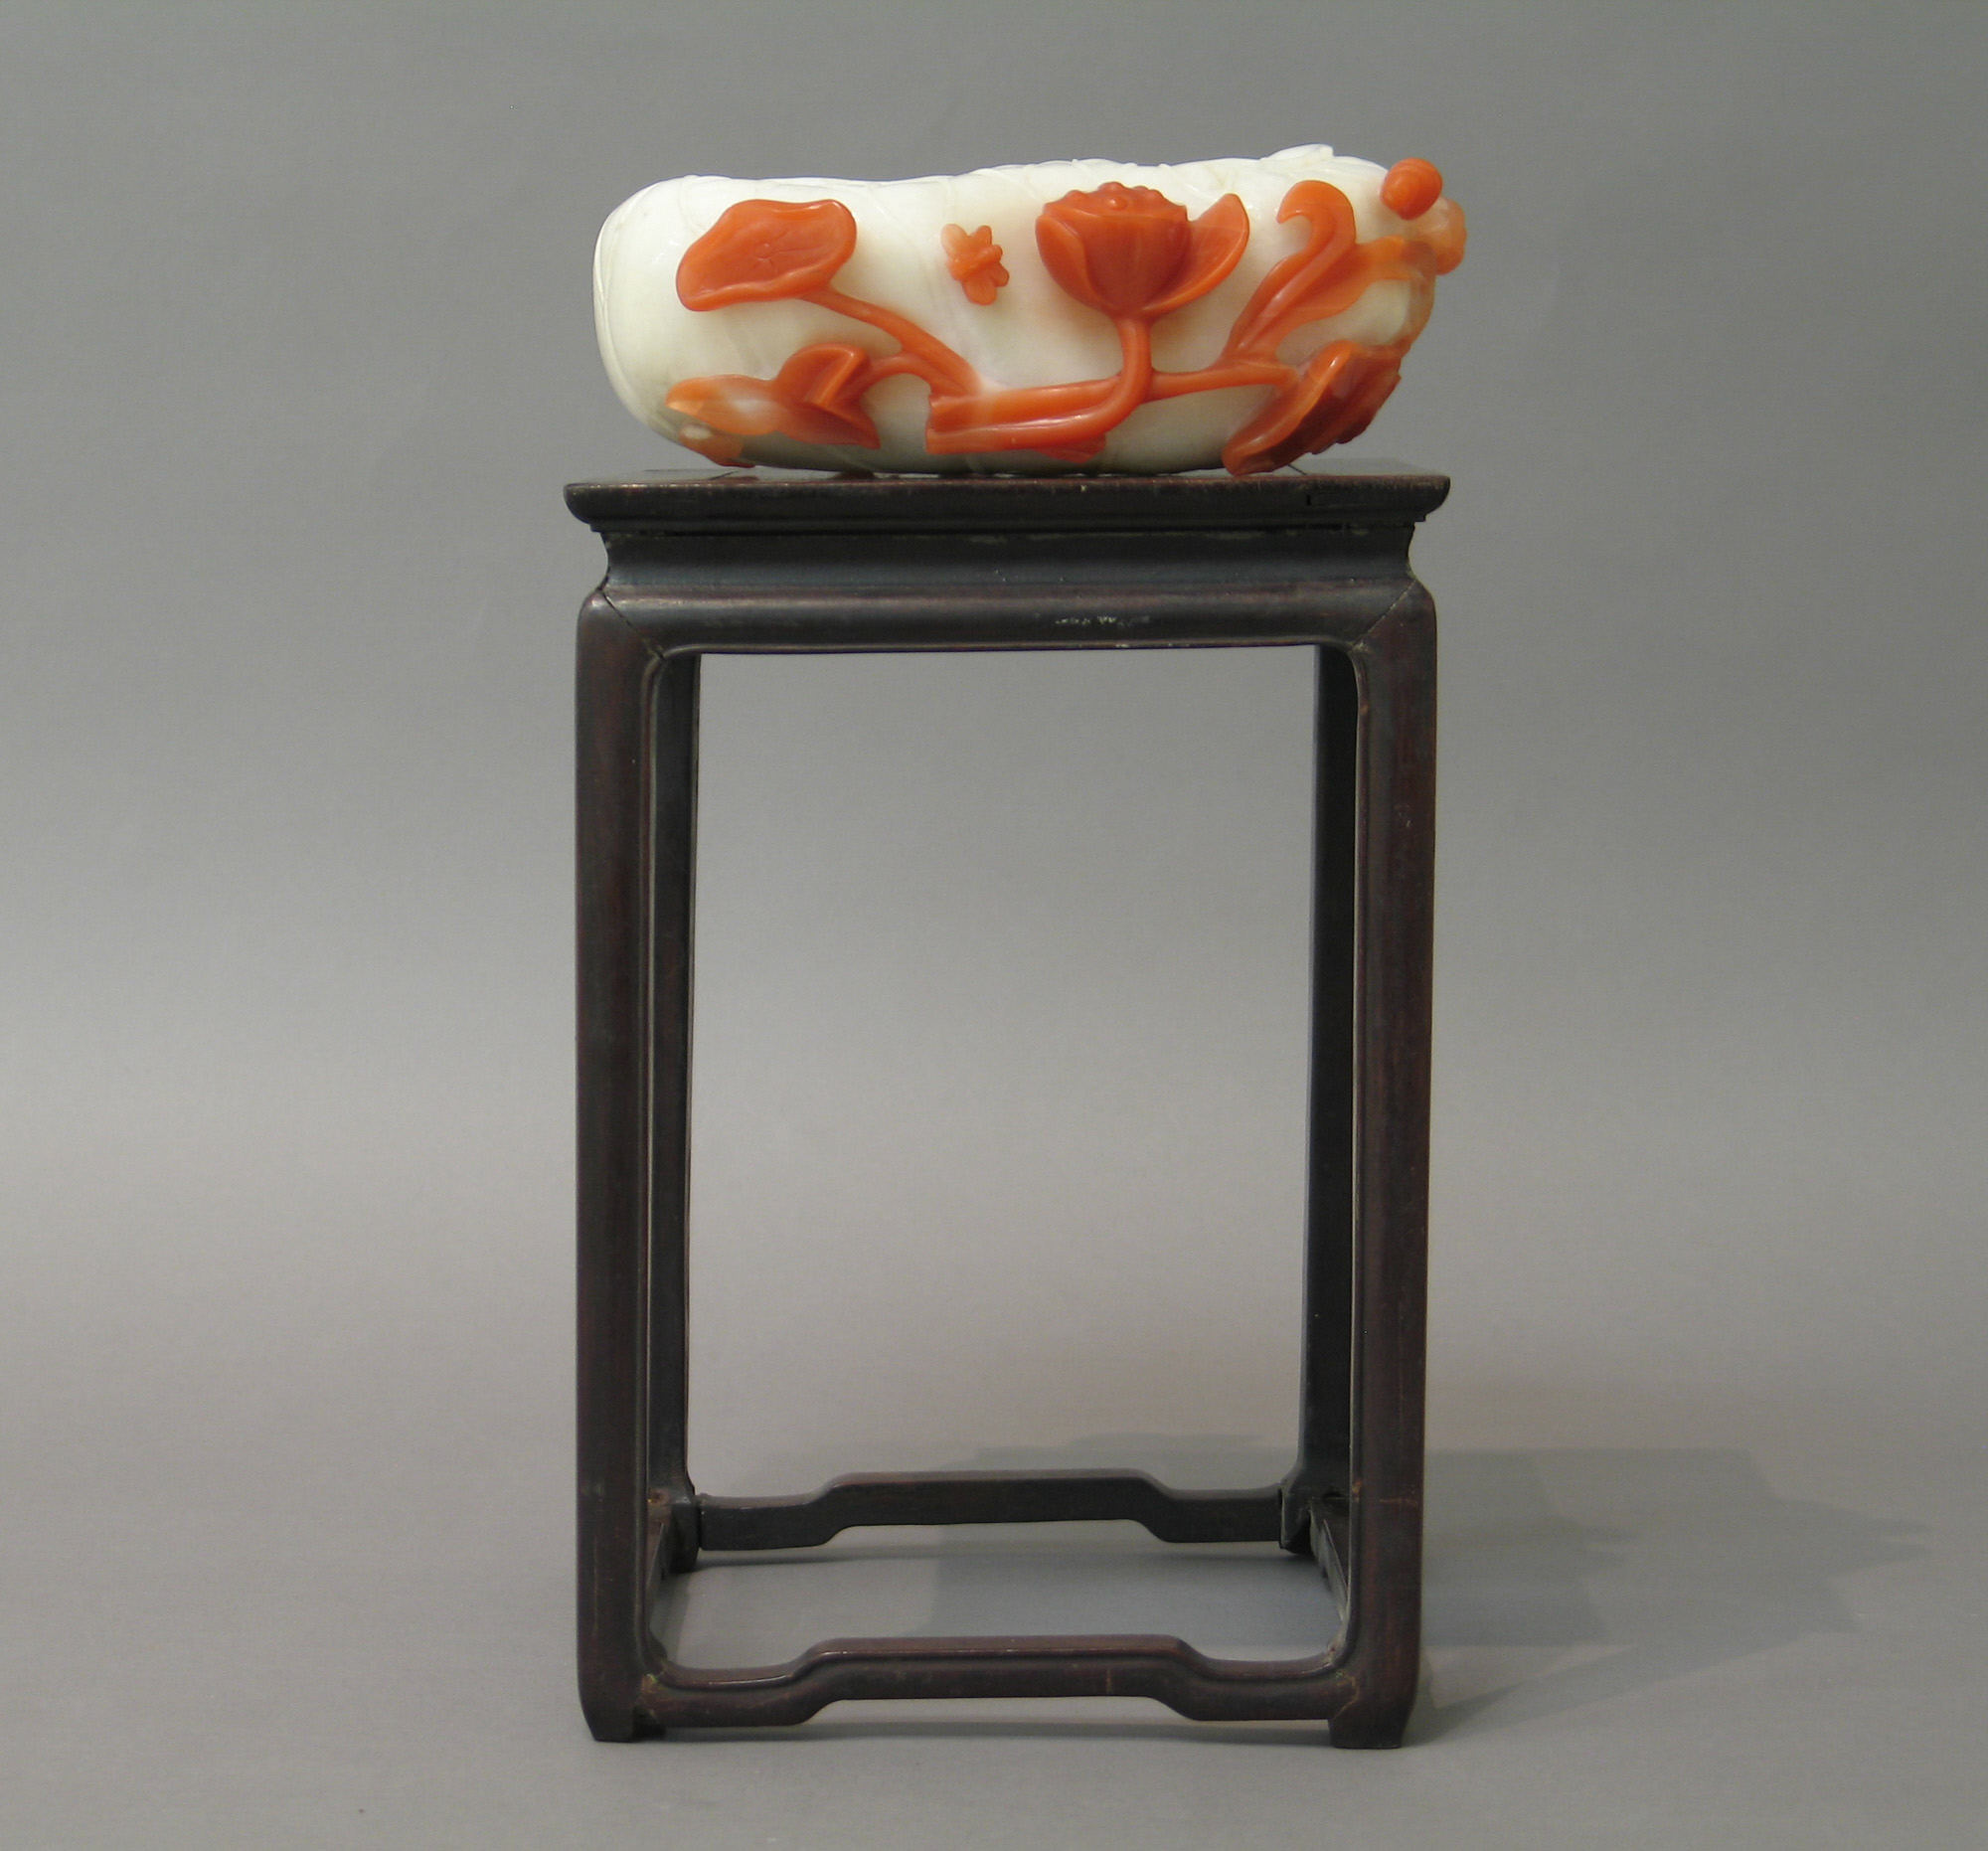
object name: dish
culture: chinese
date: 1701-1800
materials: stone, gemstone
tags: flowers